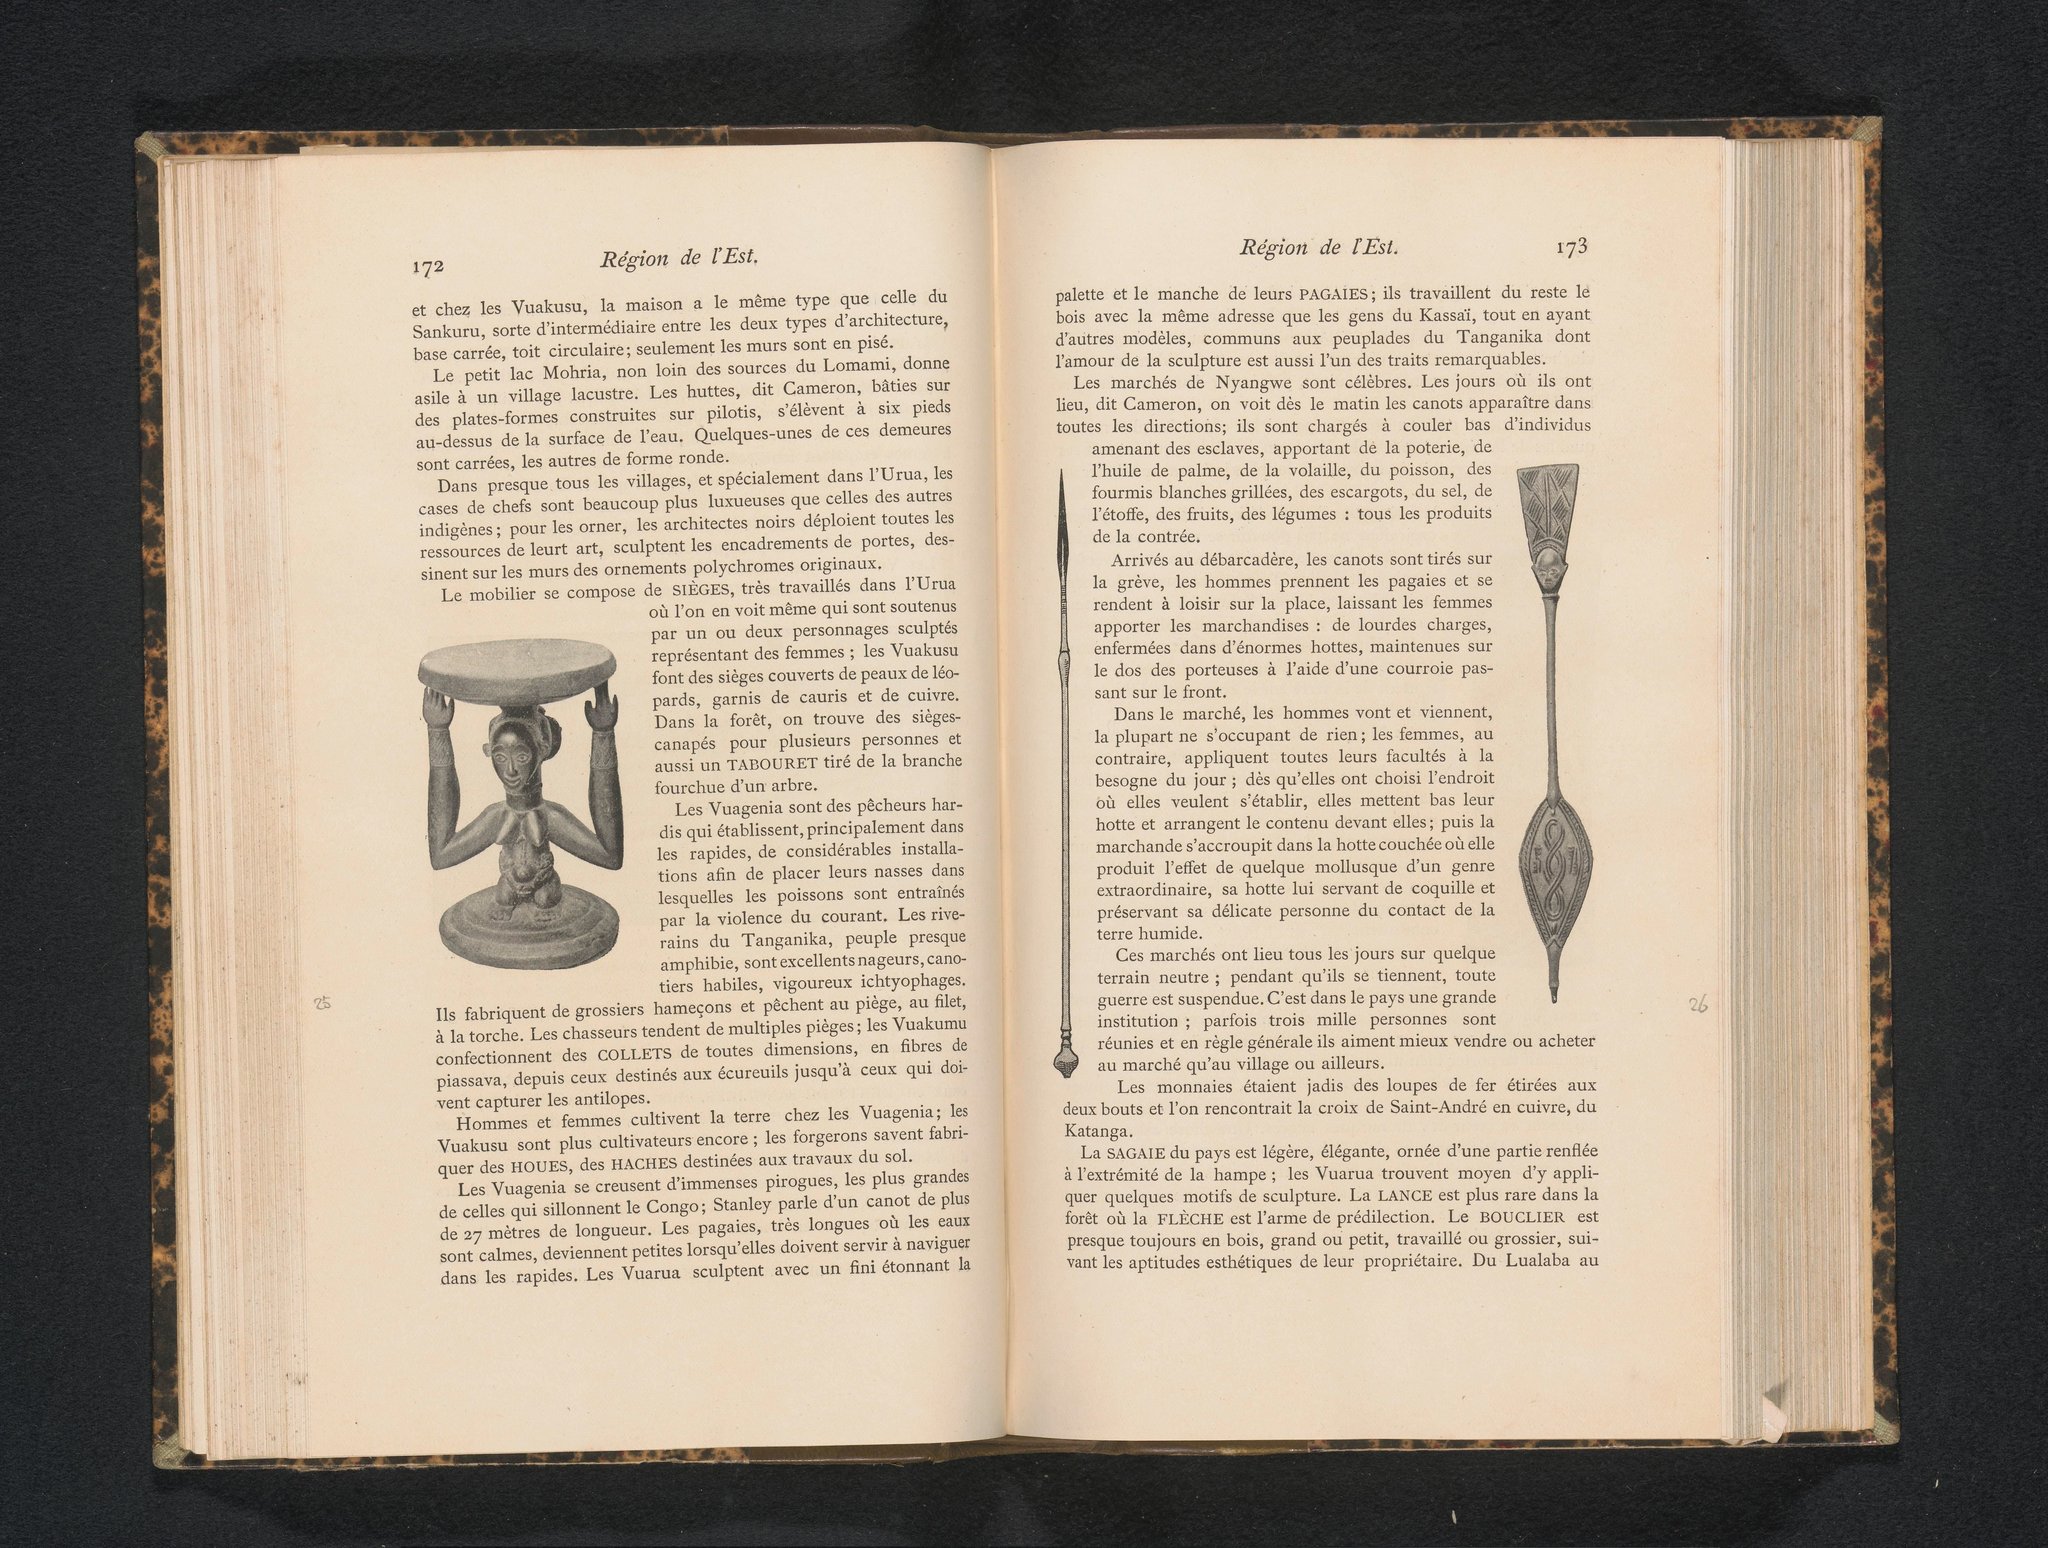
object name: page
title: Ornament uit Congo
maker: Anonymous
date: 1887-1892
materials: paper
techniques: autotype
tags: sculpture